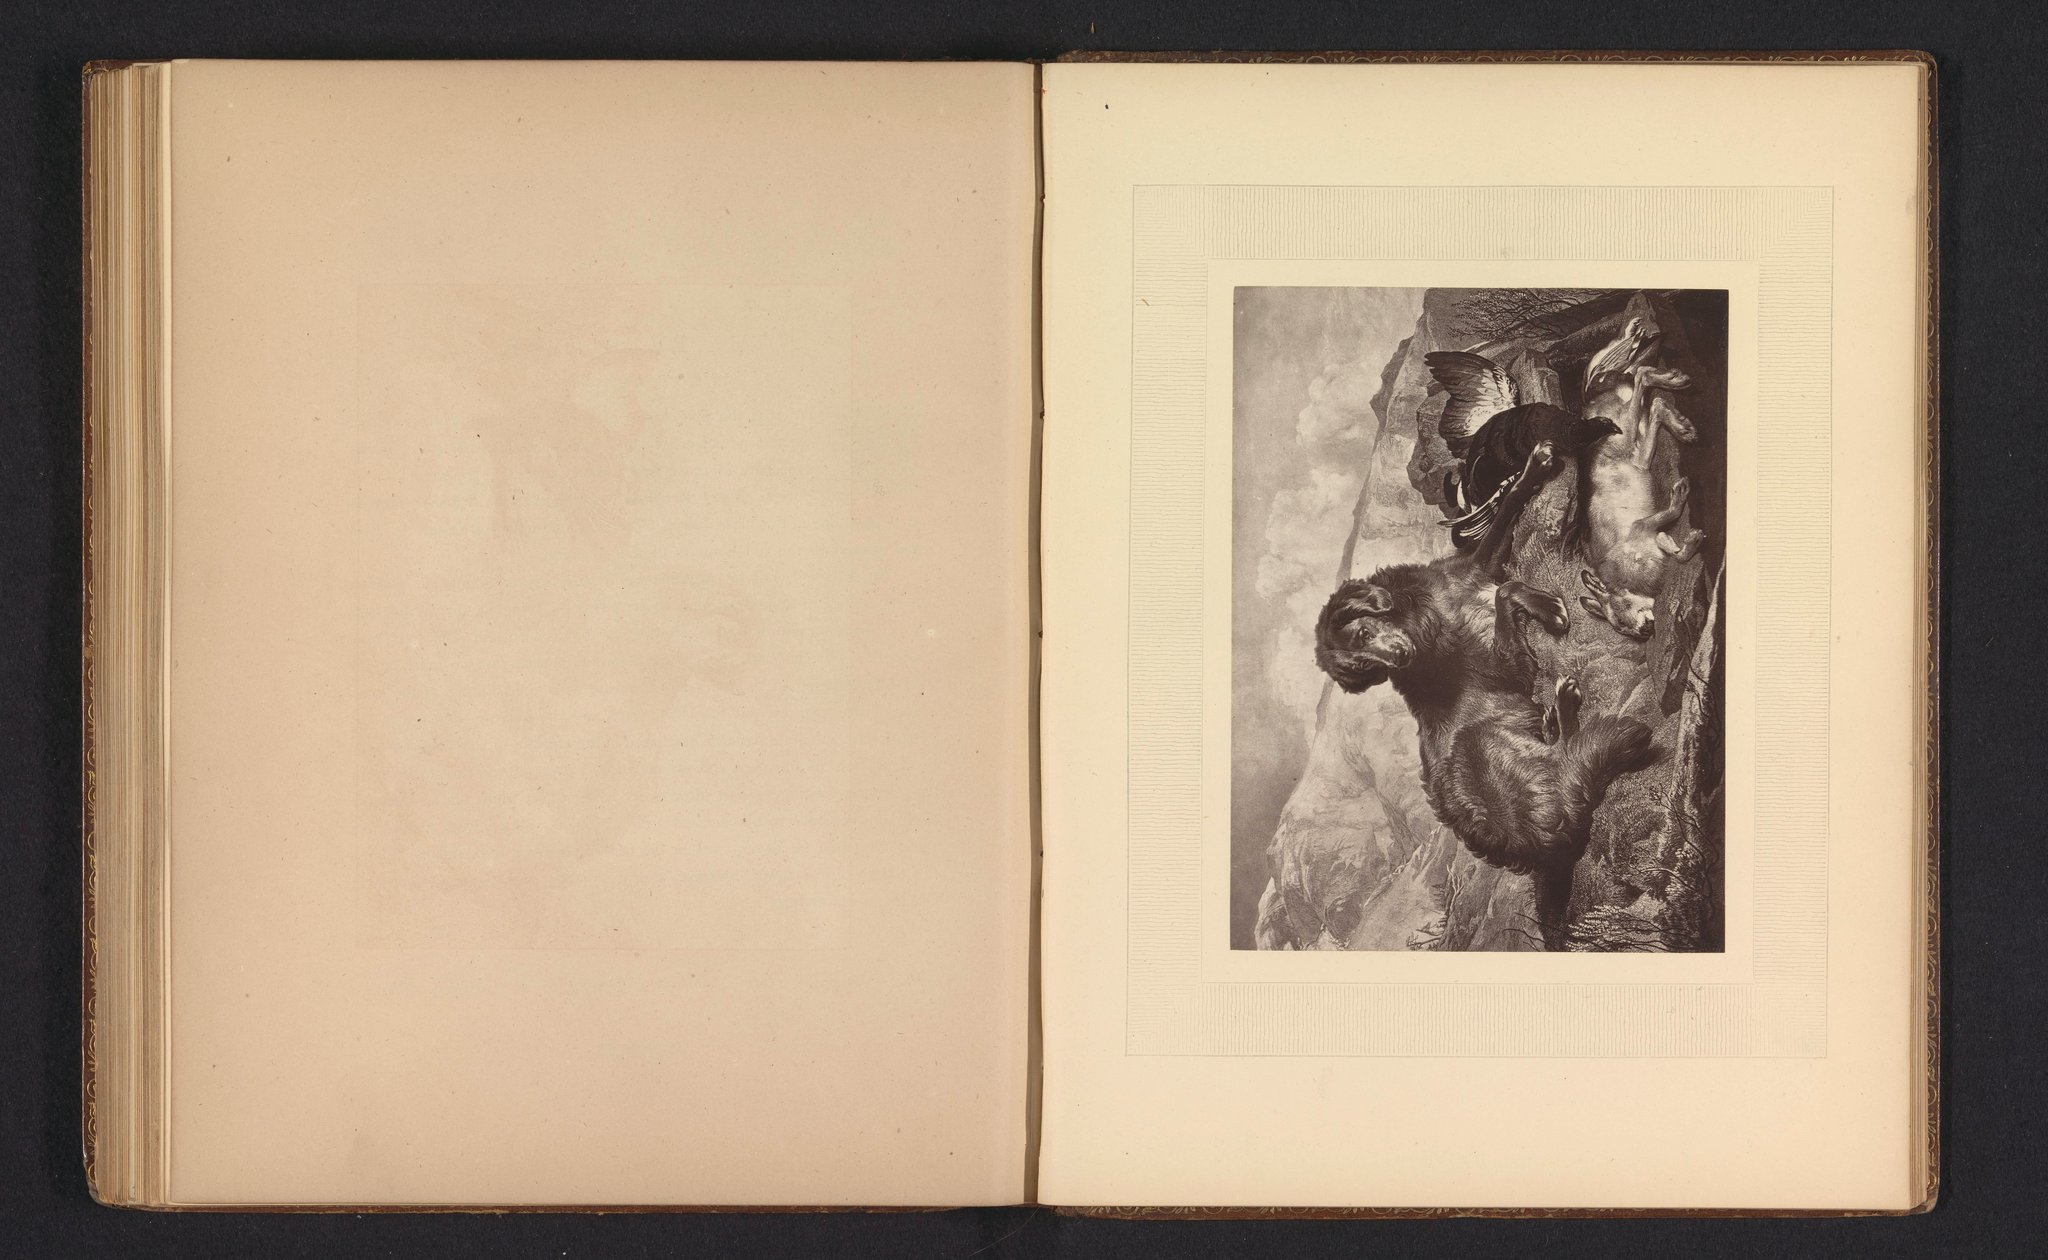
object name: photomechanical print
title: Fotoreproductie van een prent naar een schilderij met een hond en twee jachttrofeeën door Edwin Henry Landseer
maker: Anonymous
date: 1864-1874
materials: paper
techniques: woodburytype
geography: london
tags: picture, painting, hunting trophies, dog